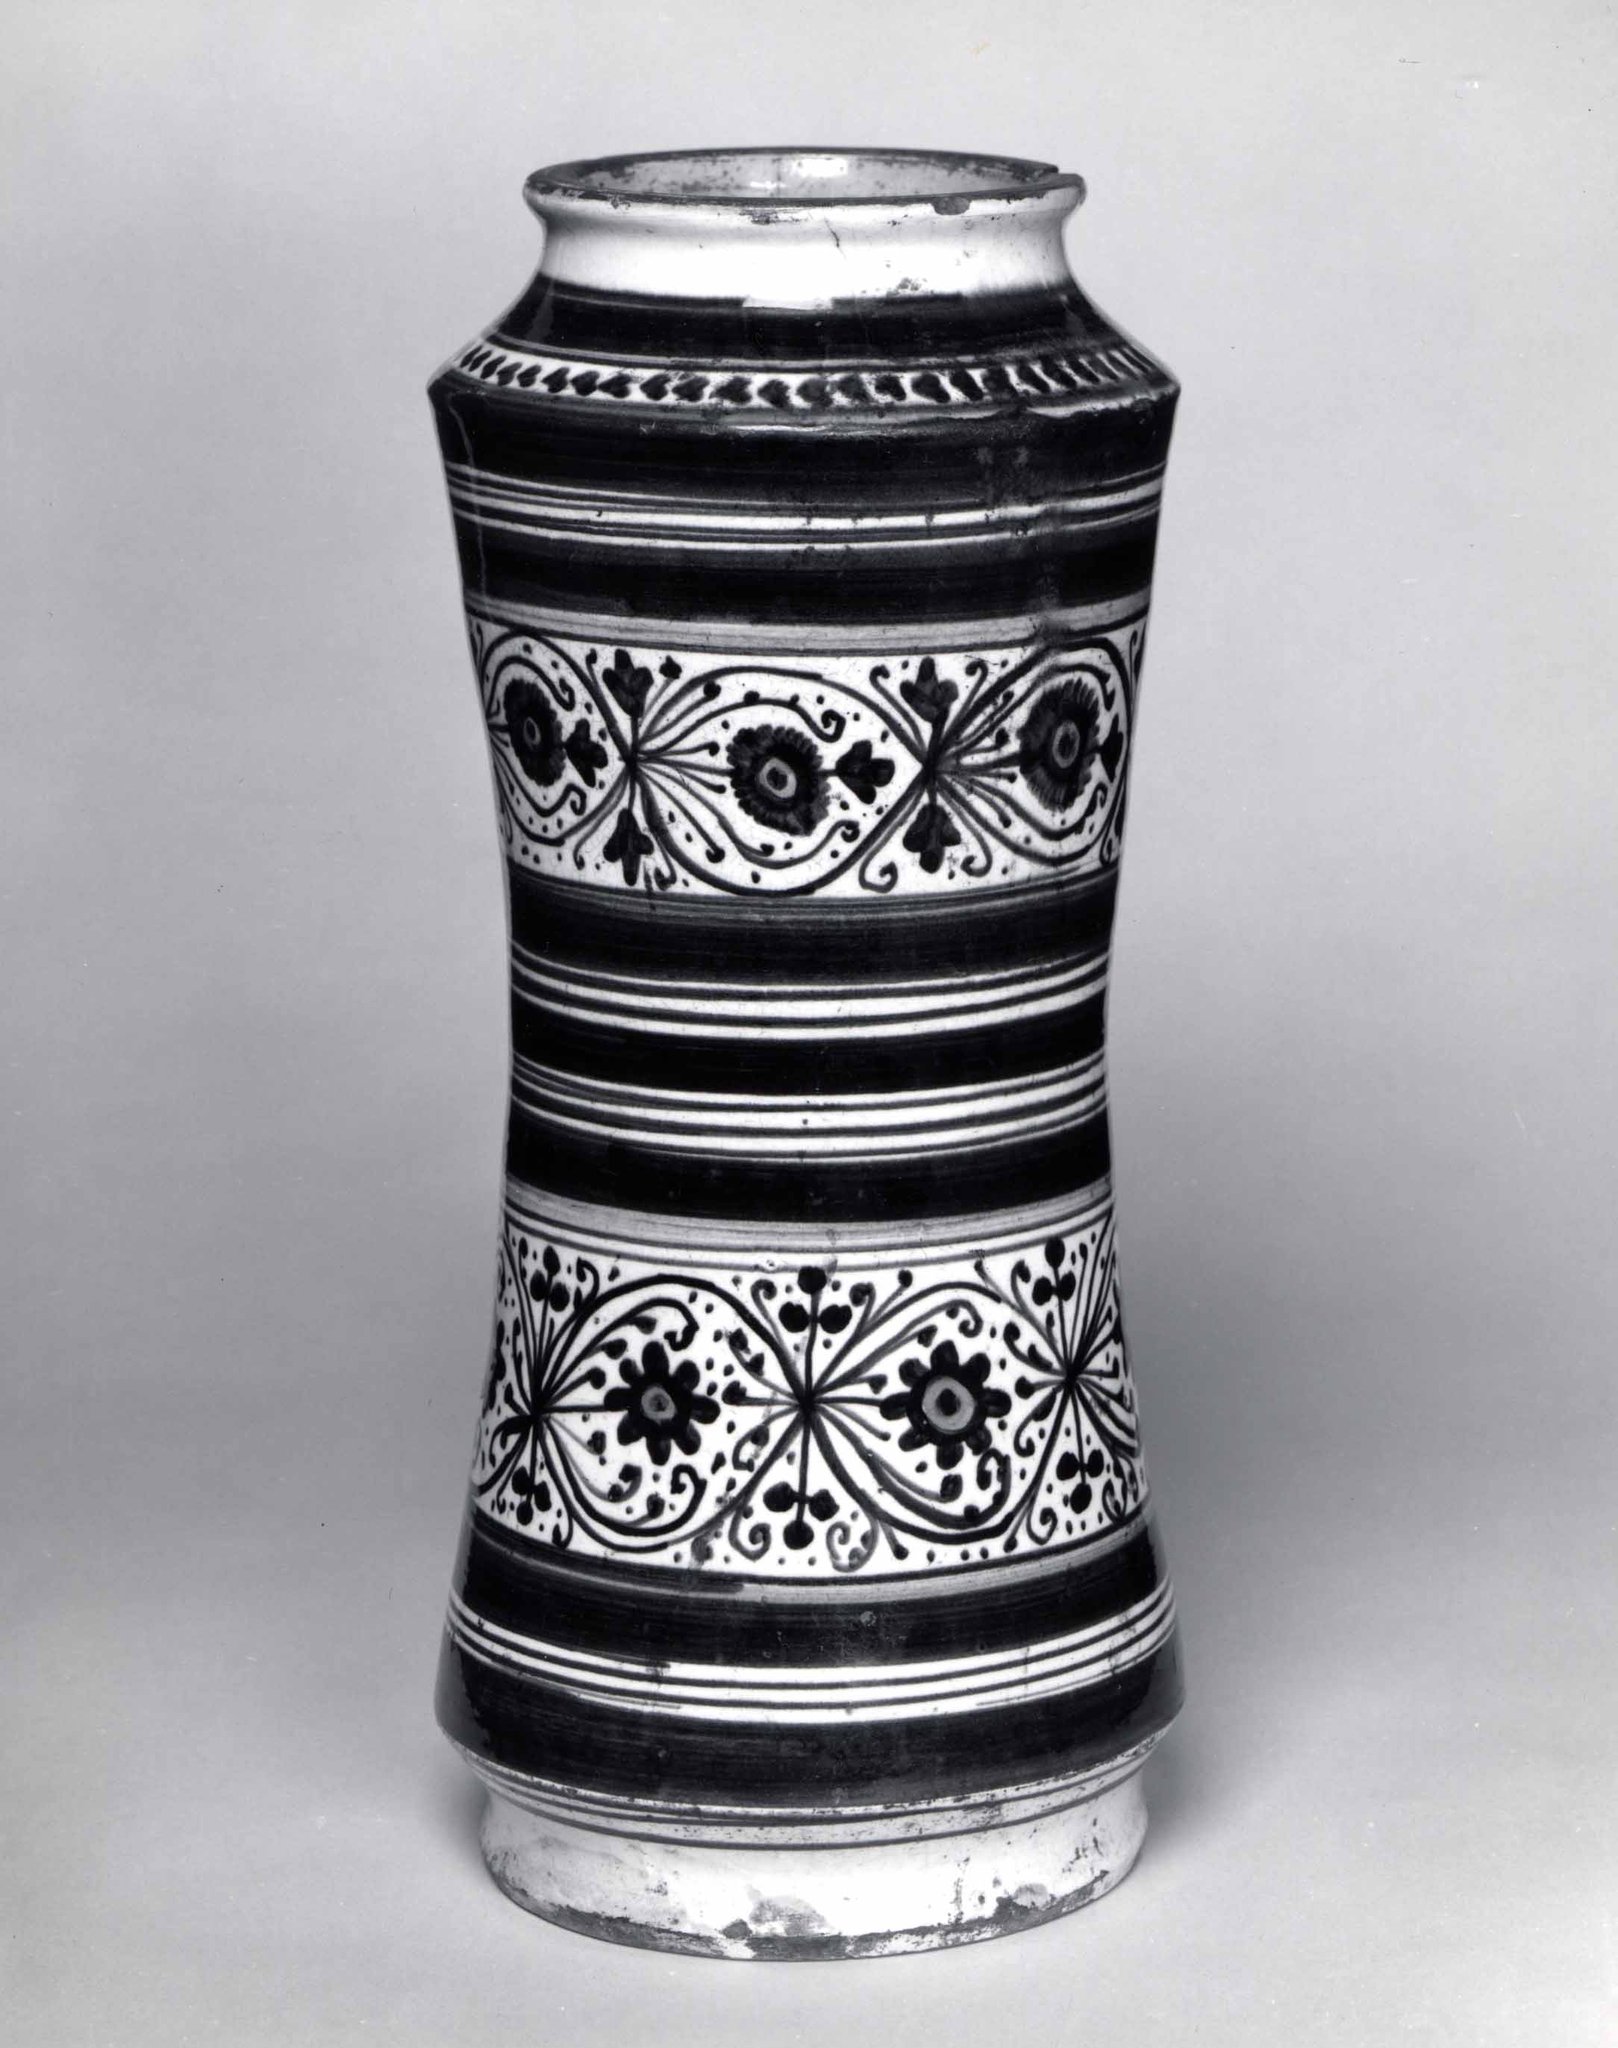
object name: albarello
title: Apothecary jar (albarello)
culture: italian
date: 1470-1480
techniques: maiolica, glazing